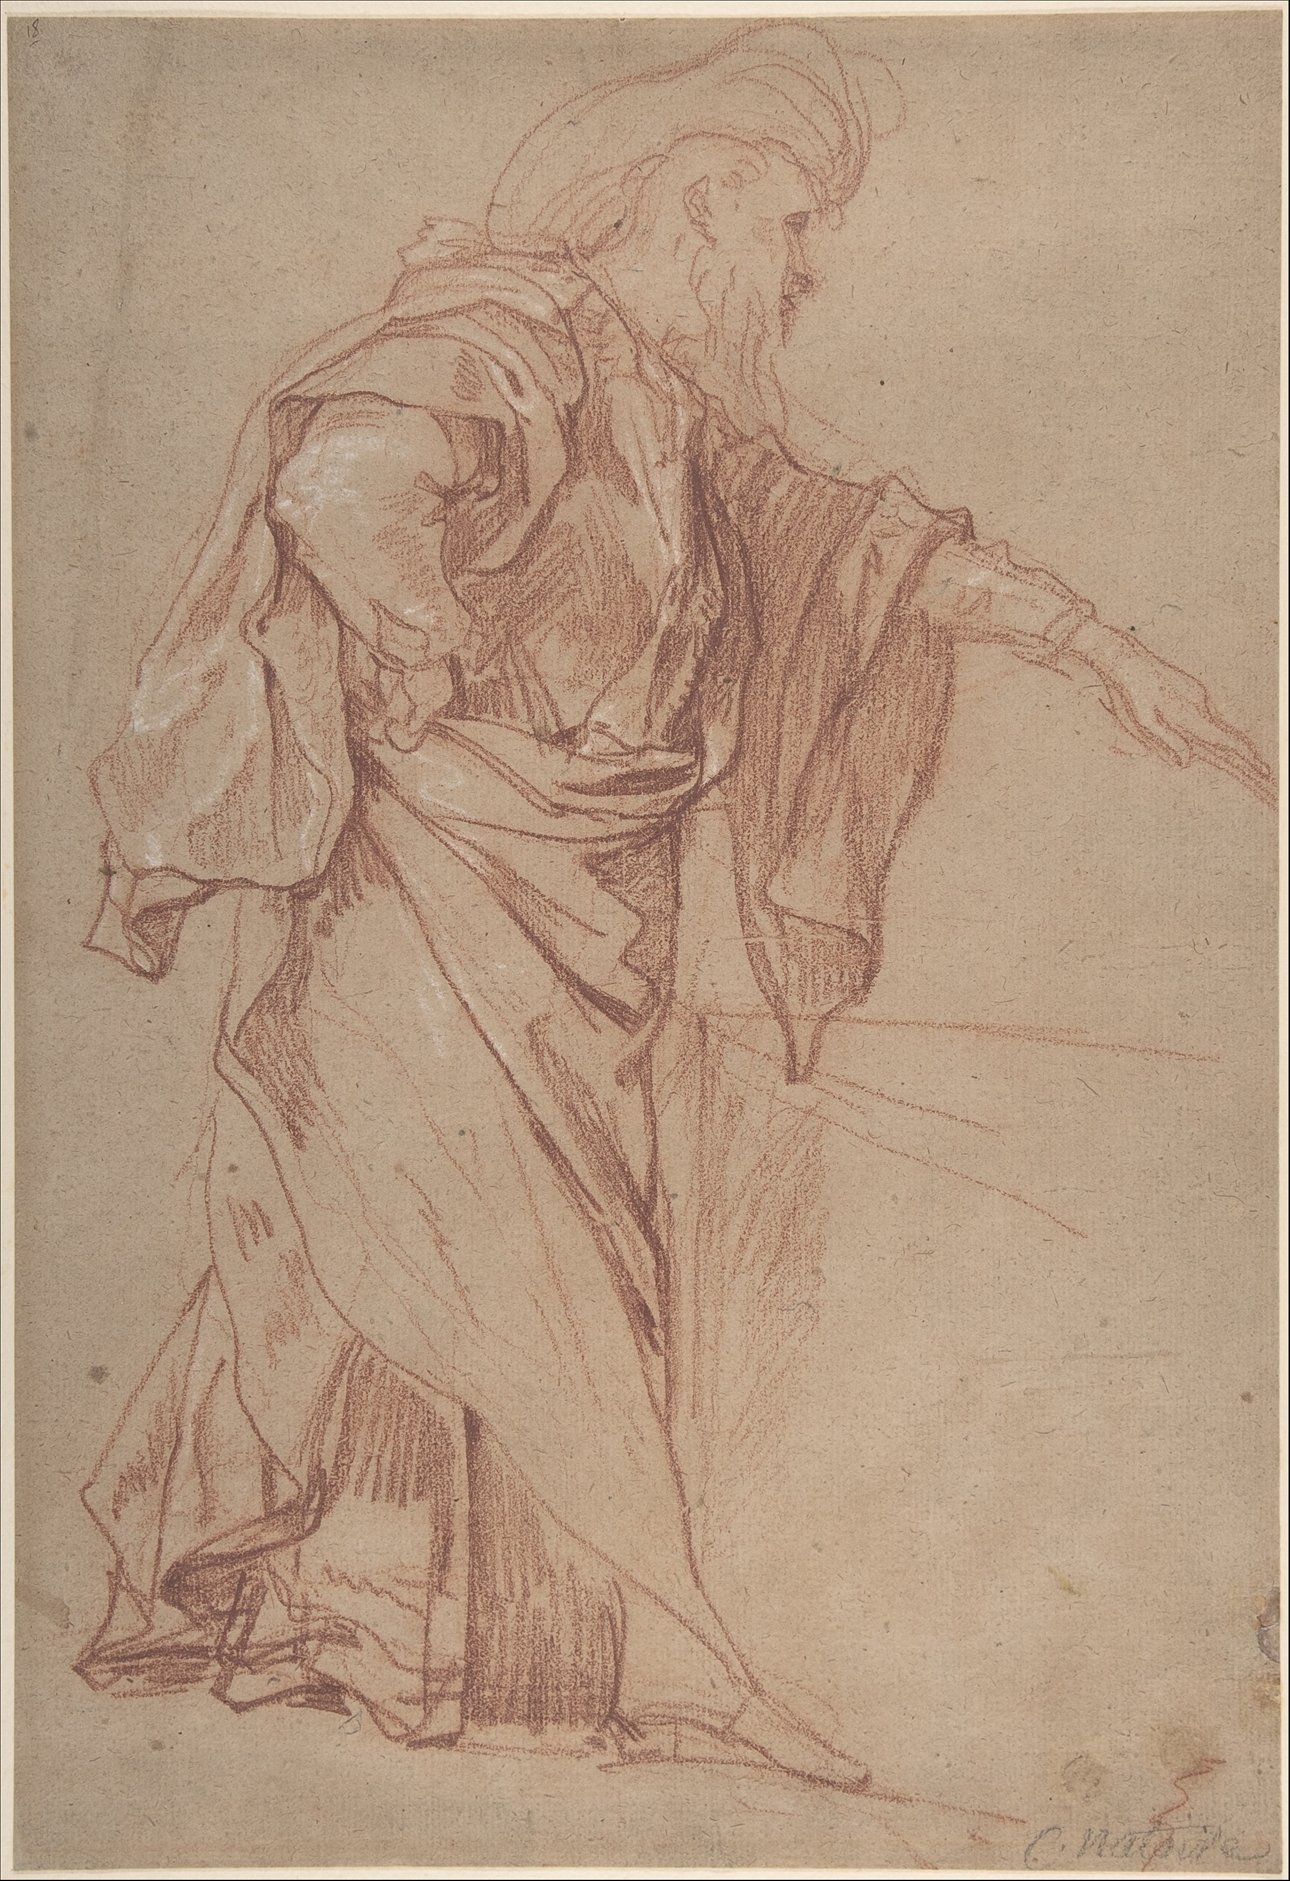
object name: drawing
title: Standing Male Figure with Left Arm Extended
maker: charles joseph natoire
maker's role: artist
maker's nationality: french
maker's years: 1700-1777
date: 1701-1800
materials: chalk, paper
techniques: heightening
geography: france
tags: men